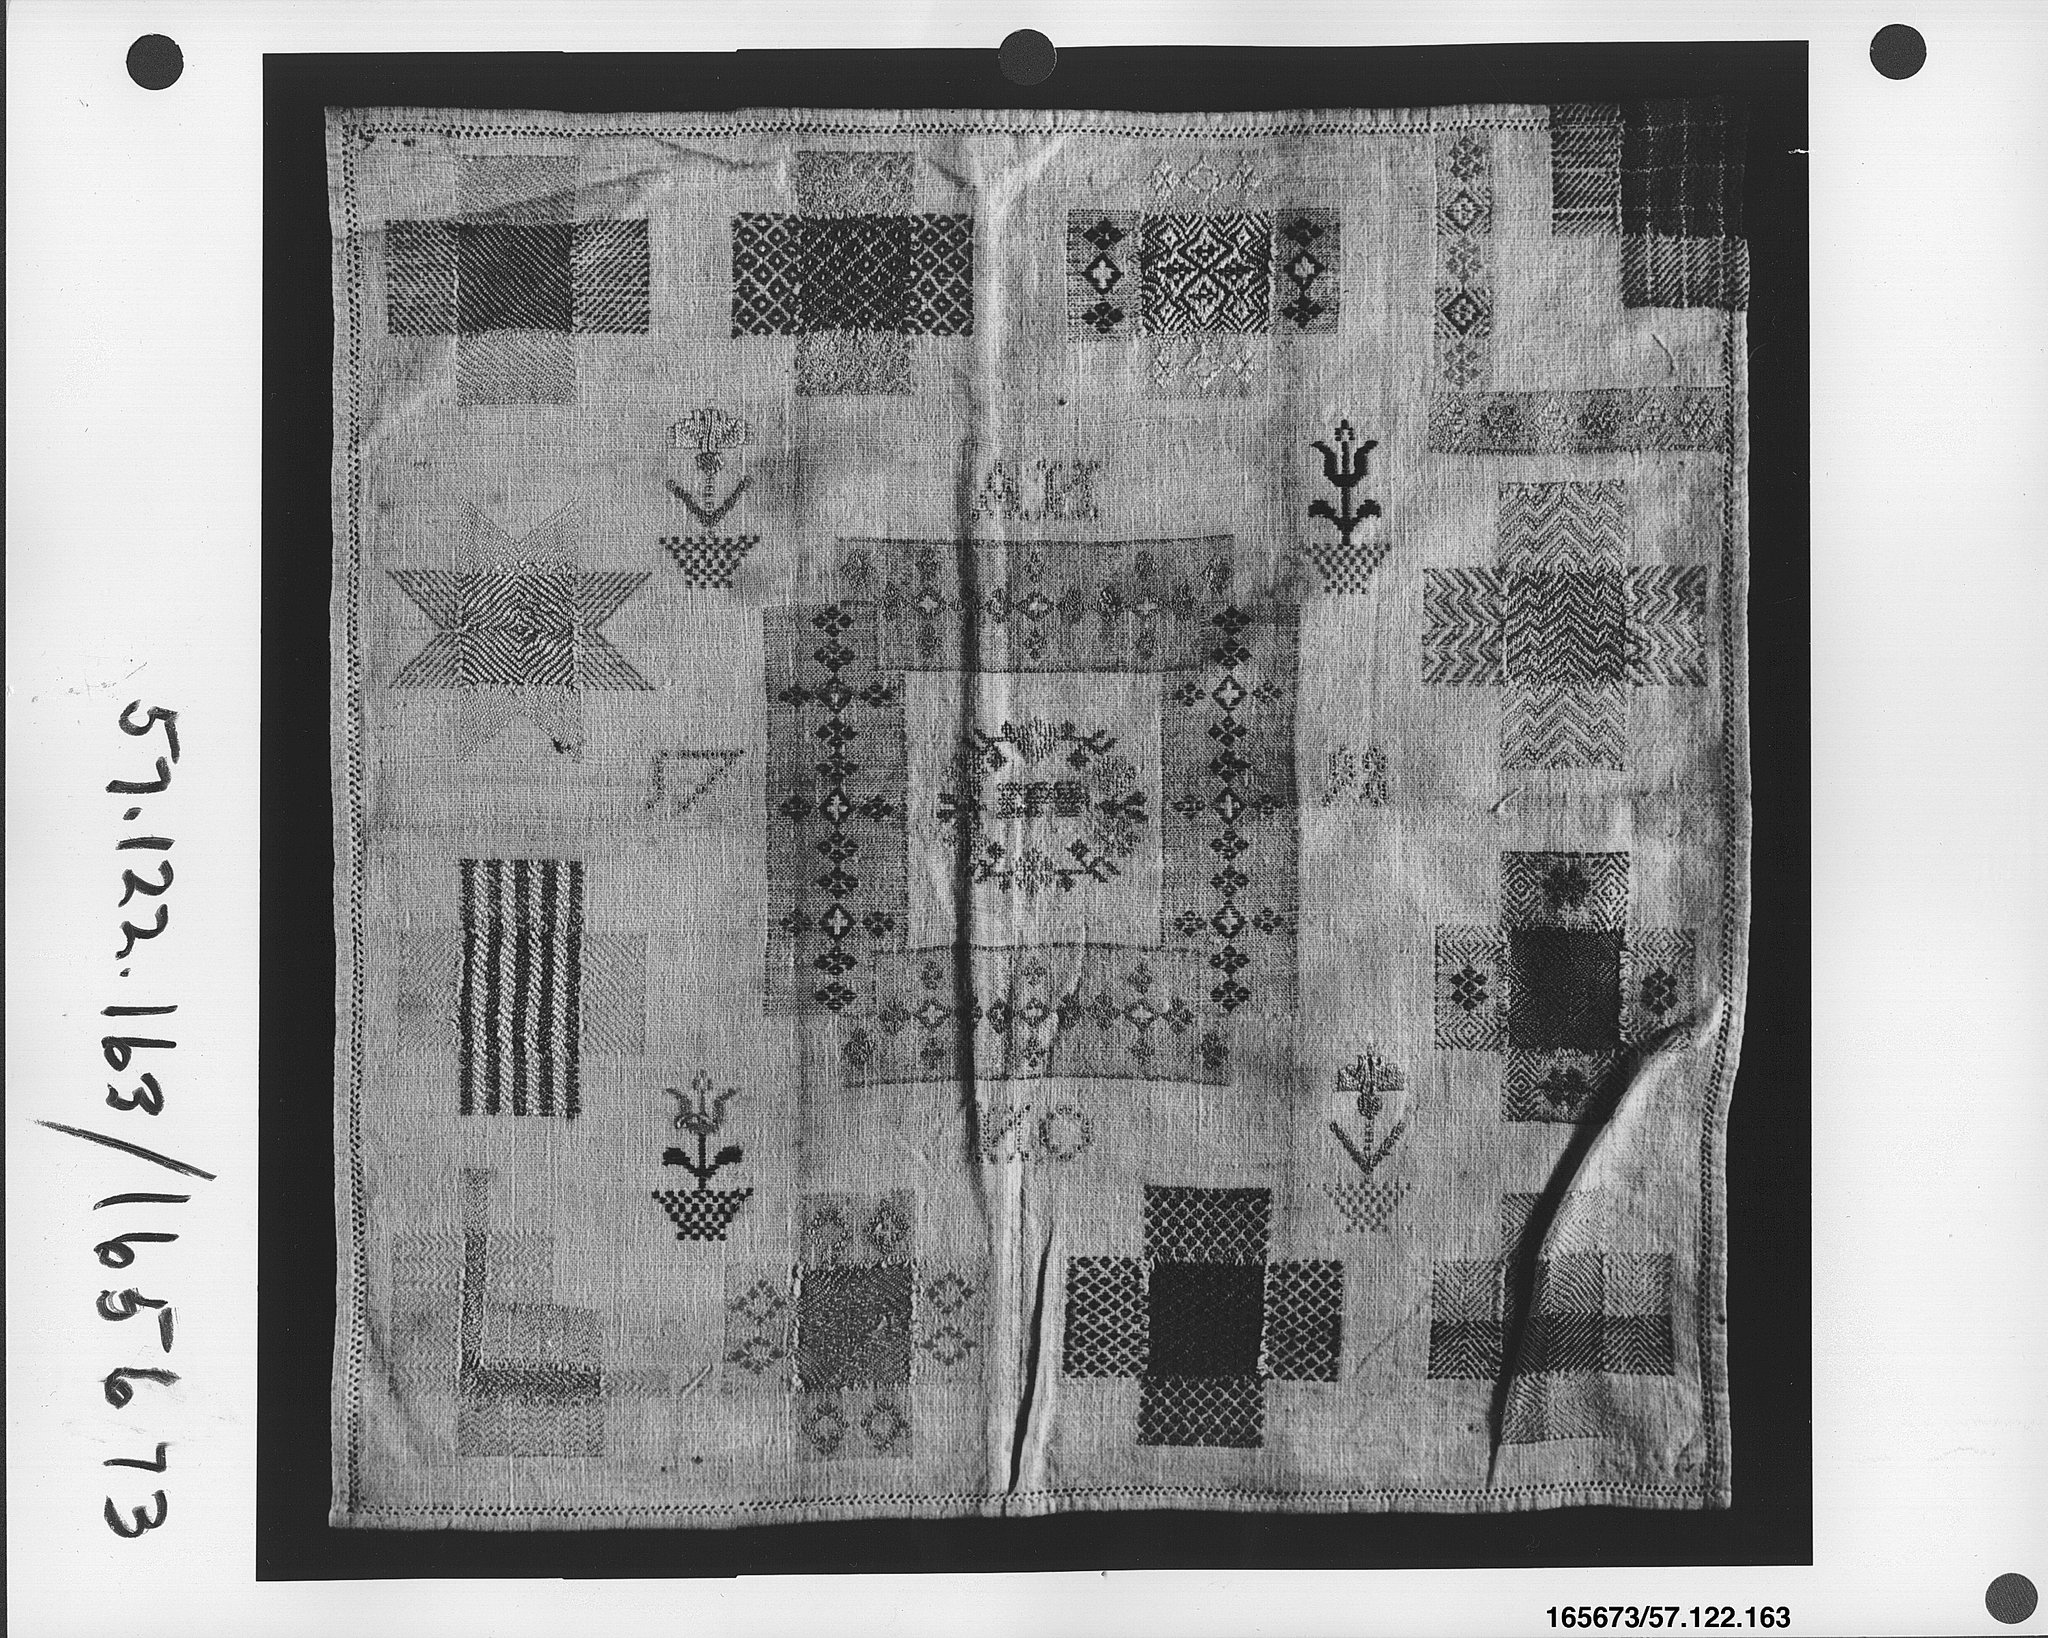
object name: sampler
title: Embroidered darning sampler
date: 1798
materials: cotton, silk